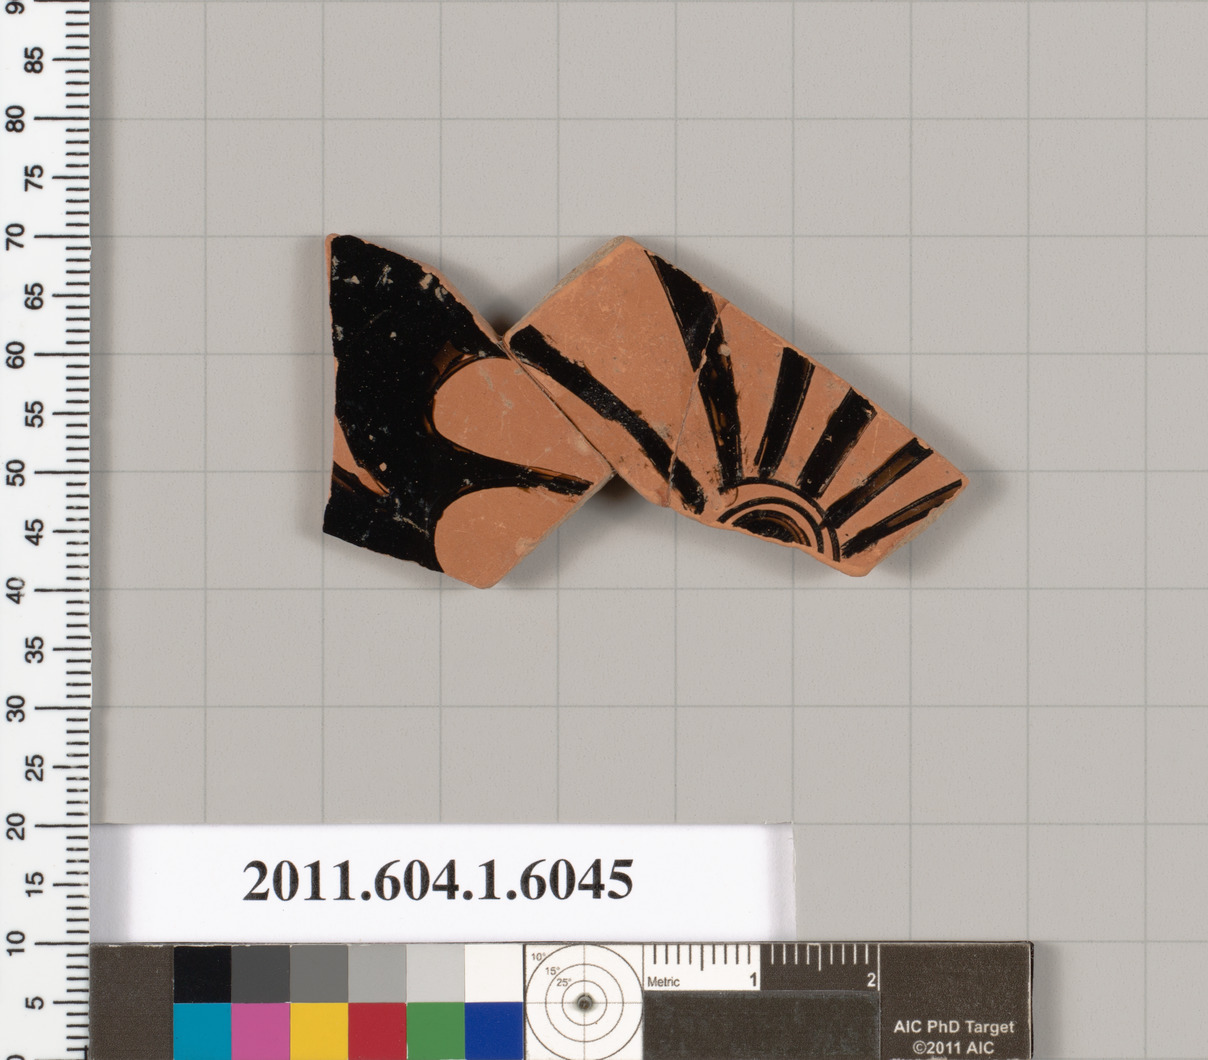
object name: kylix fragment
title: Terracotta fragment of a kylix (drinking cup)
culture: greek, attic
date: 510-500 BCE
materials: terracotta